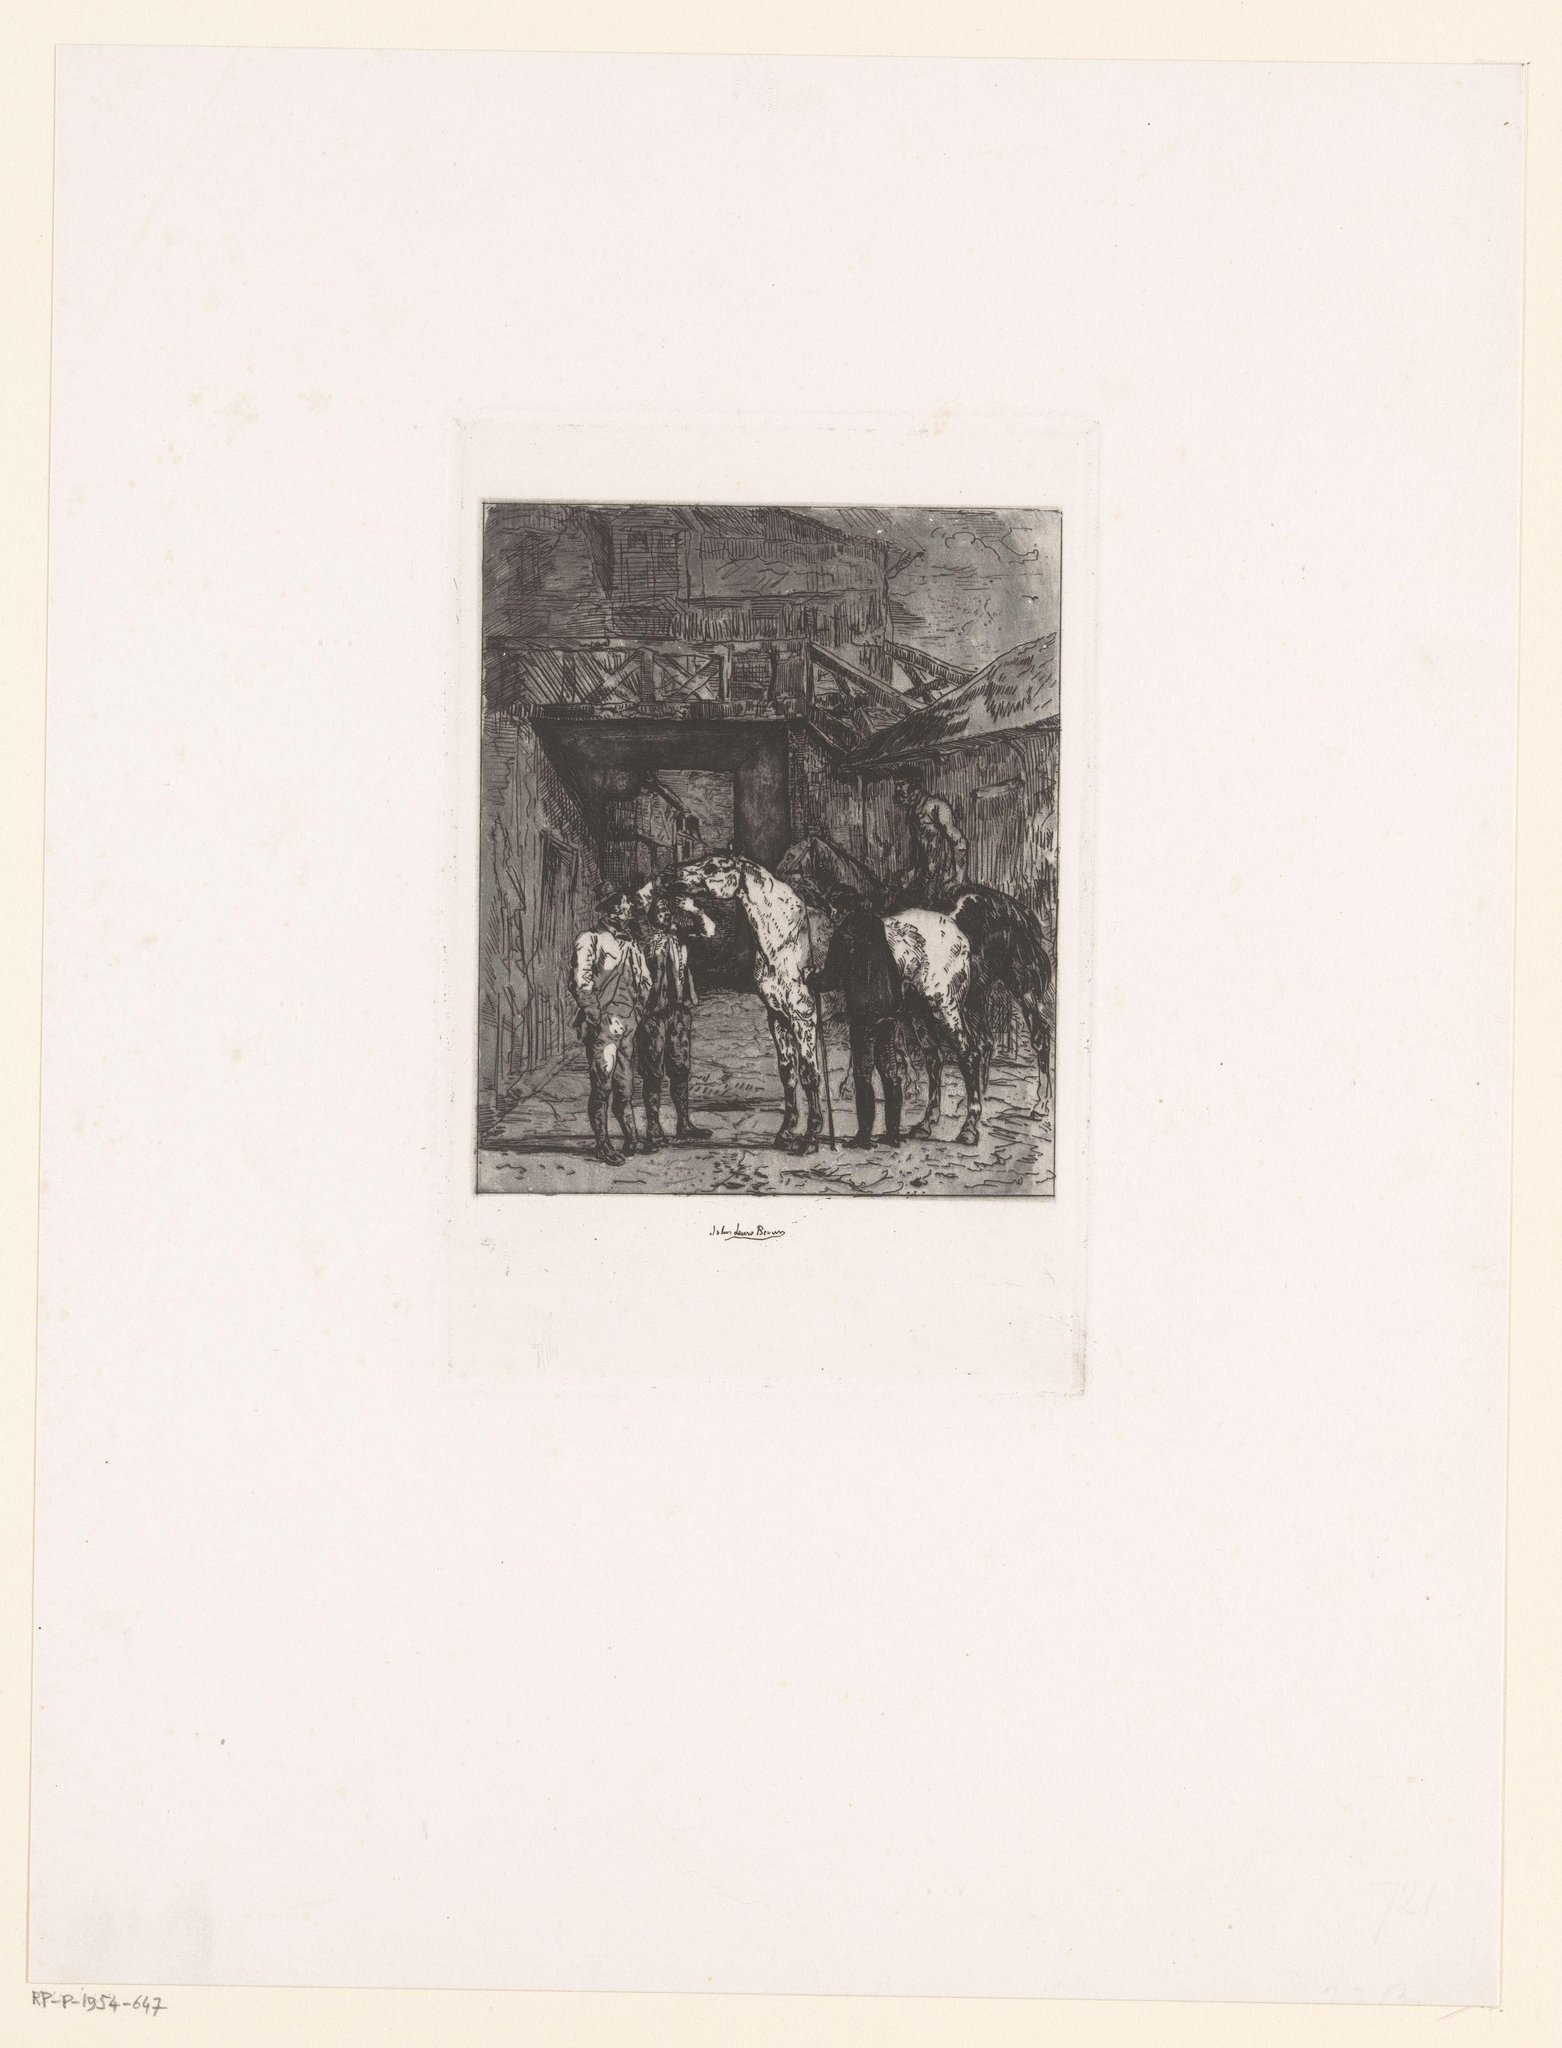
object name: print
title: Vier mannen en twee paarden bij een stal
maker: john lewis brown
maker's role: print maker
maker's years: 1829-1890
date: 1839-1890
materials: paper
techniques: aquatint, etching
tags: horse, stall, stable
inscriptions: collector's mark: Lugt 2228, collector's mark: Lugt 2760